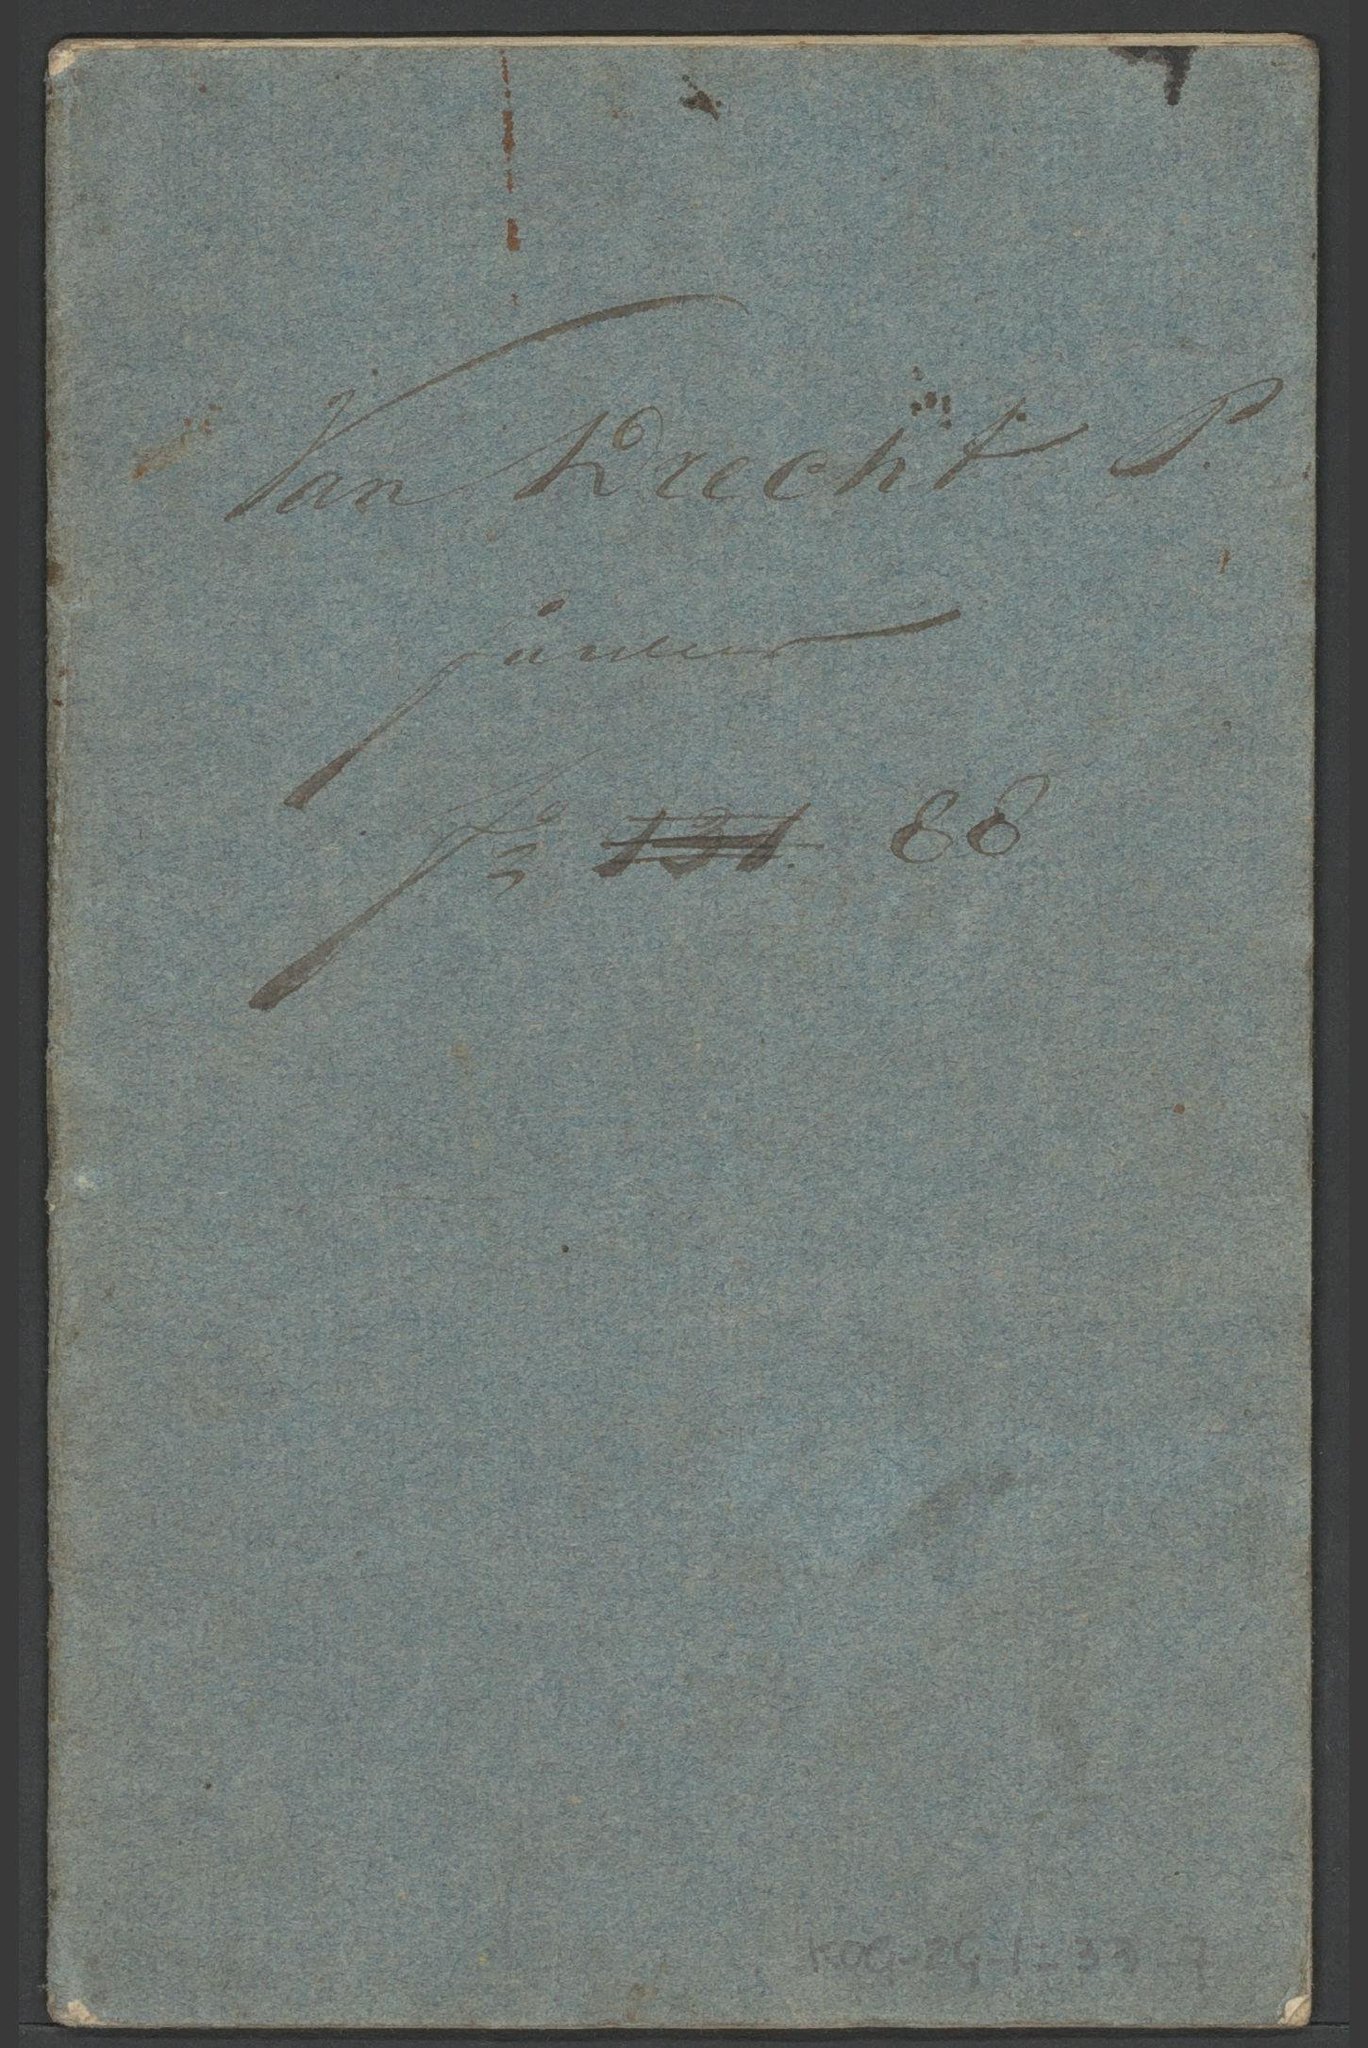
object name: paybook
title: Militair zakboekje van Jan Drecht Pietersz., 1830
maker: Anonymous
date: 1830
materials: paper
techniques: handwriting, letterpress printing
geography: amsterdam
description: Militair zakboekje van Jan Drecht Pietersz., milicien soldaat in het Compagnie letter E, 2e Bataljon 9e Regiment Infanterie. Afgegeven op 1 april 1831, met aantekeningen tot en met het jaar 1911.